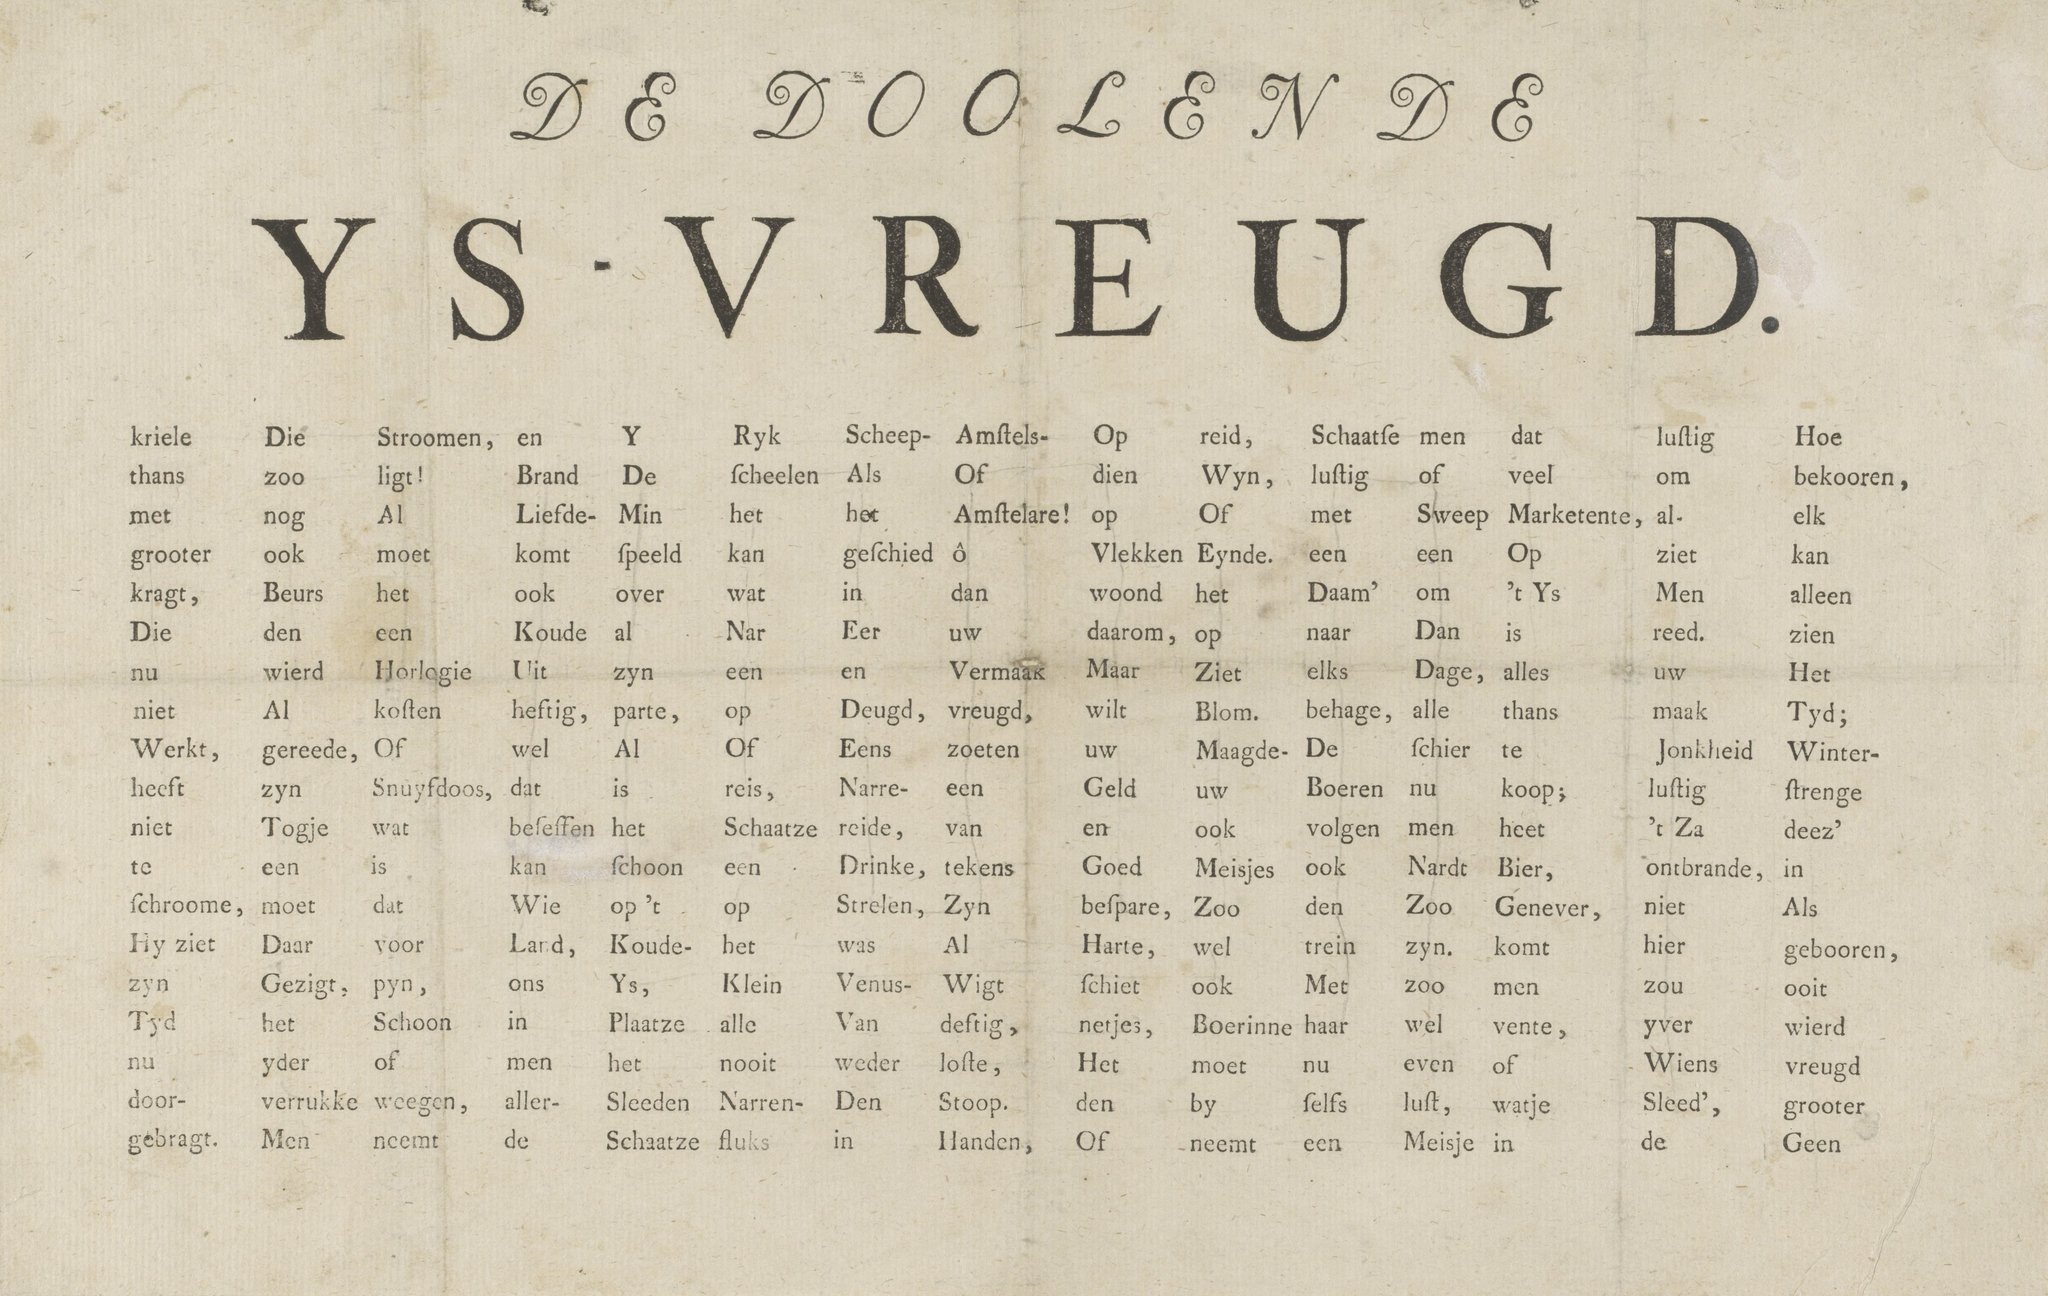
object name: print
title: De doolende ys-vreugd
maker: Anonymous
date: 1700-1899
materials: paper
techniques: letterpress printing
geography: netherlands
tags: cross-word puzzle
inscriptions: collector's mark: Lugt 2760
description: Een puzzel met als thema winter, waarbij woorden tot zinnen verbonden moeten worden.